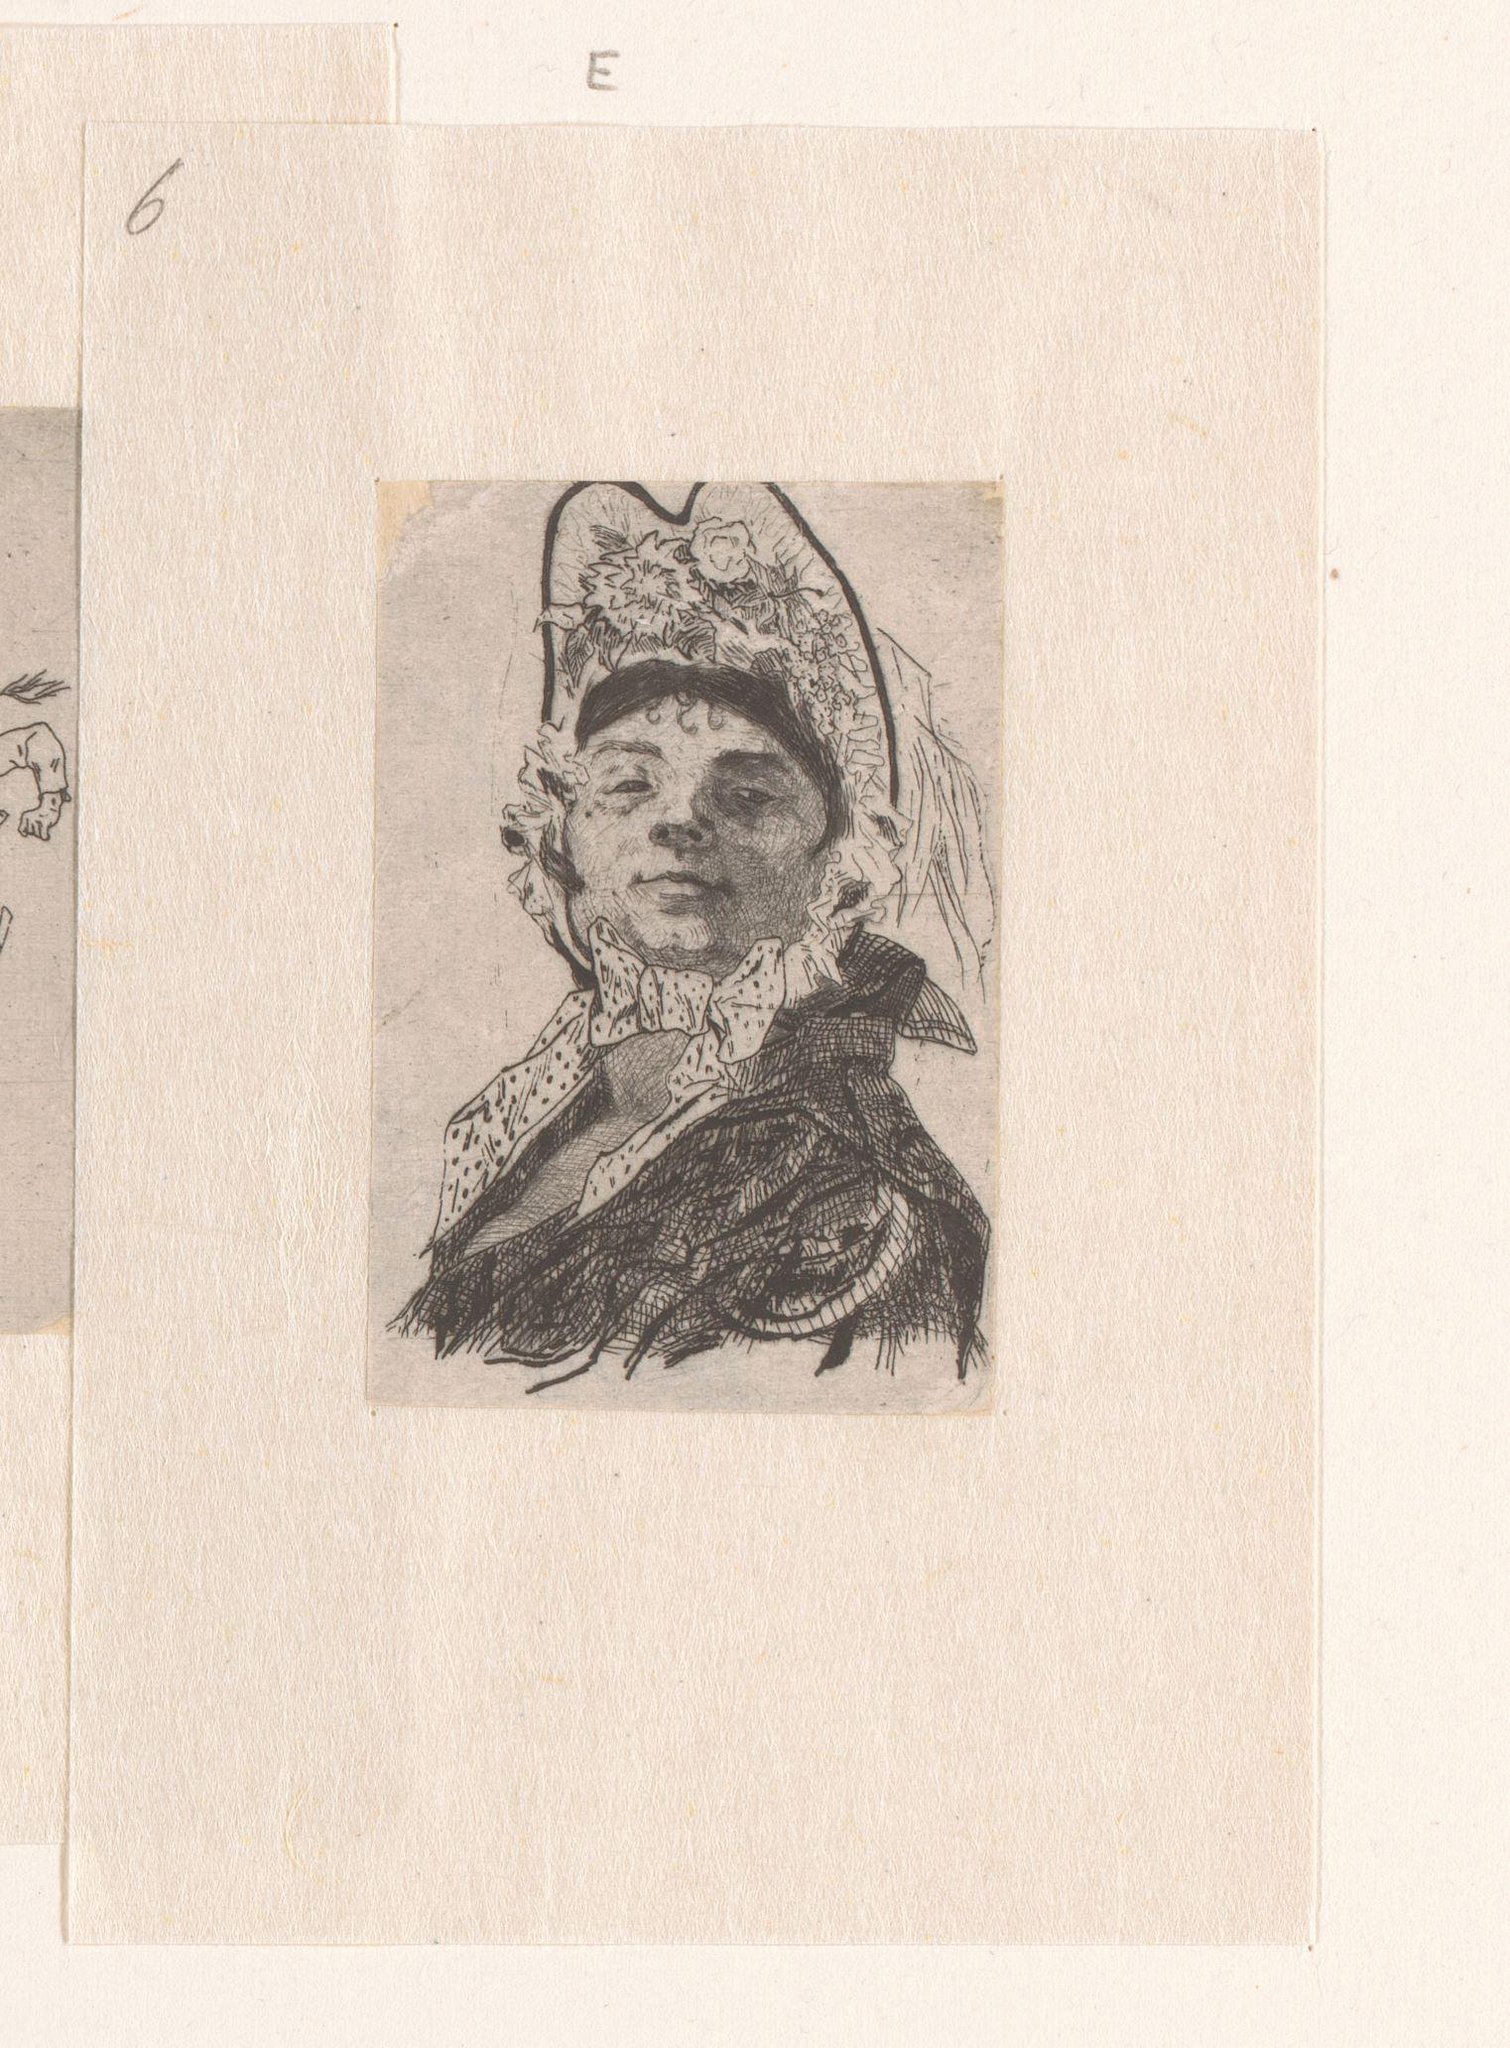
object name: print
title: Les cythères parisiennes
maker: félicien rops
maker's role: draughtsman, print maker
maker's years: 1833-1898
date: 1863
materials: paper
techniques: etching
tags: adult woman, head-gear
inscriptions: collector's mark: Lugt 2228